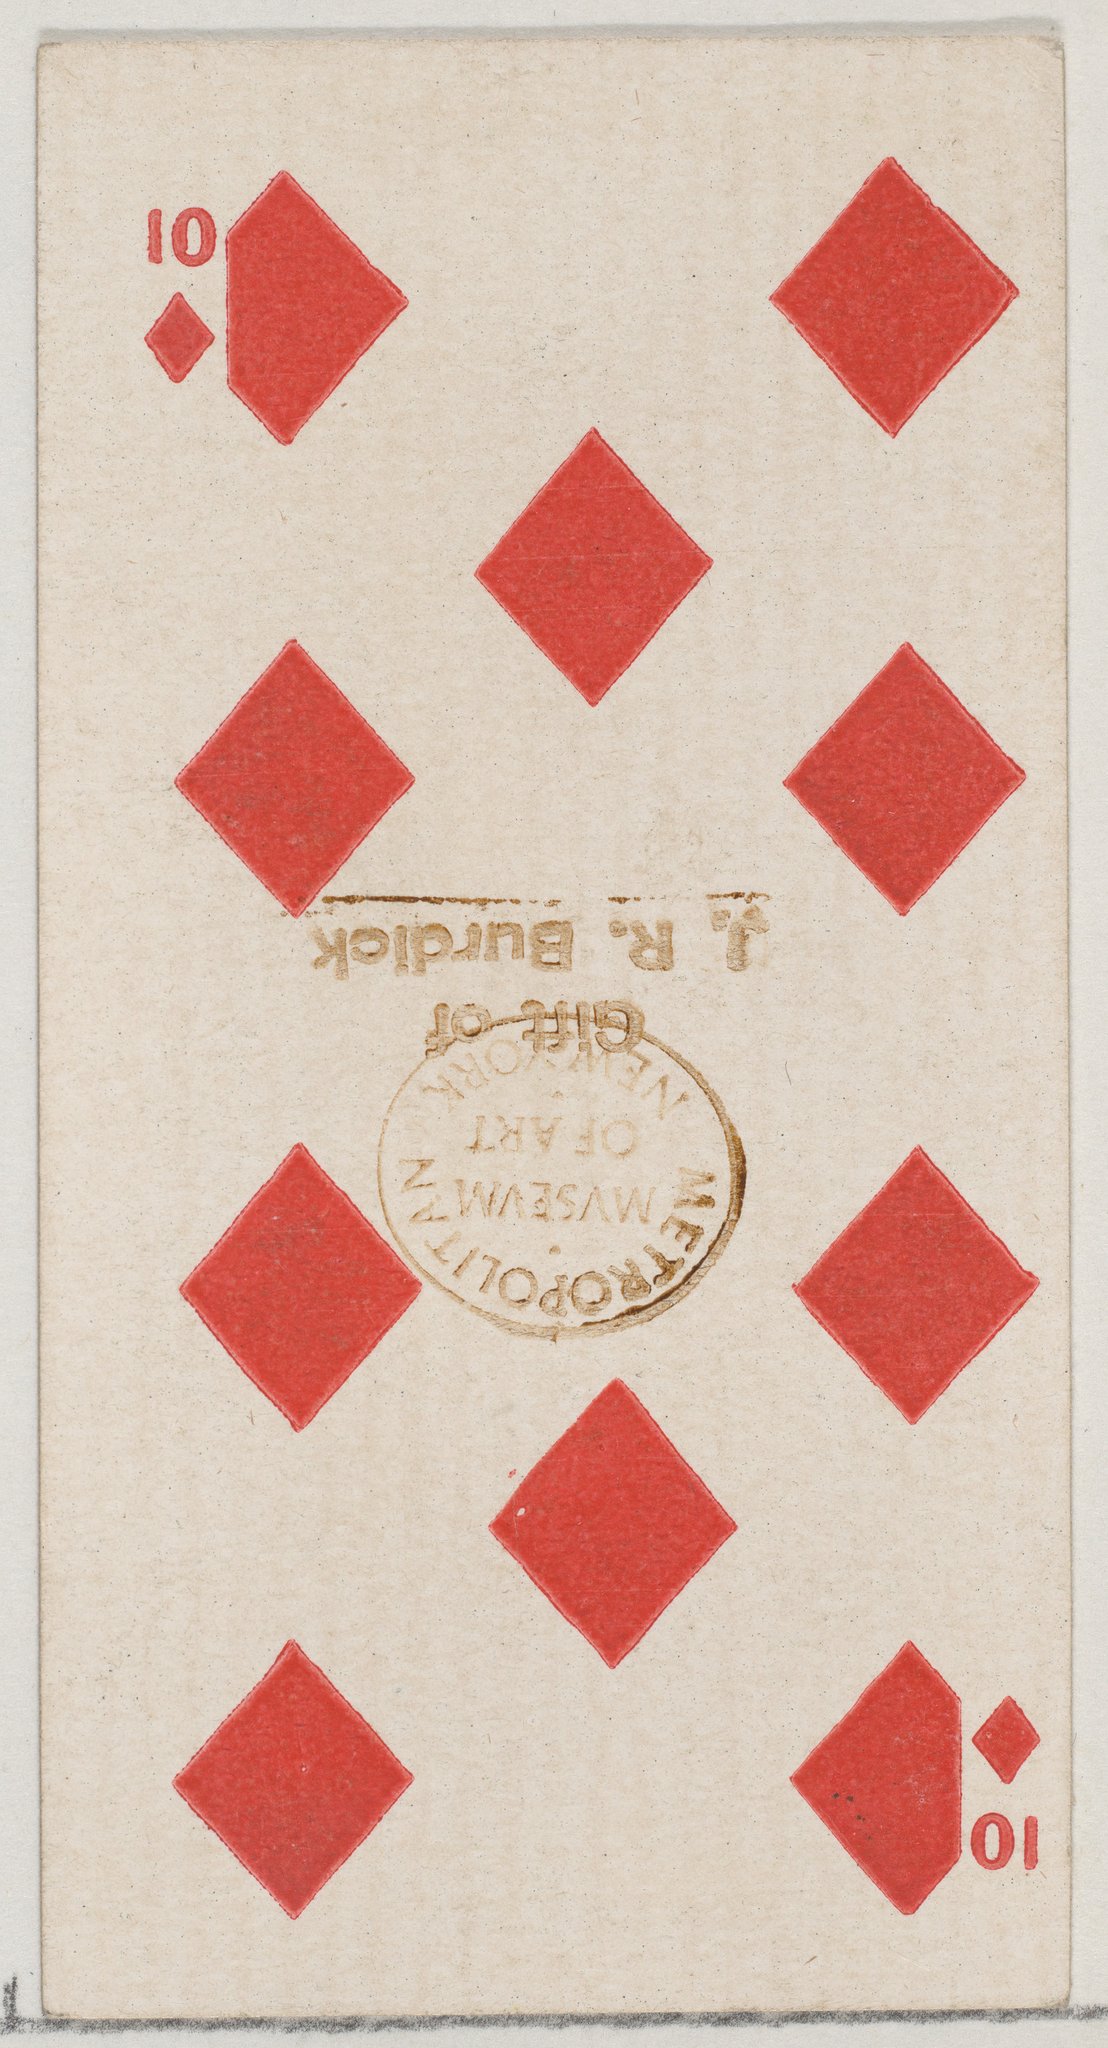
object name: print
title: Ten Diamonds (red), from the Playing Cards series (N84) for Duke brand cigarettes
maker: w. duke, sons & co.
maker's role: publisher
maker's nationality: american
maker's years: 1870-1920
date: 1888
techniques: color lithograph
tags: playing cards